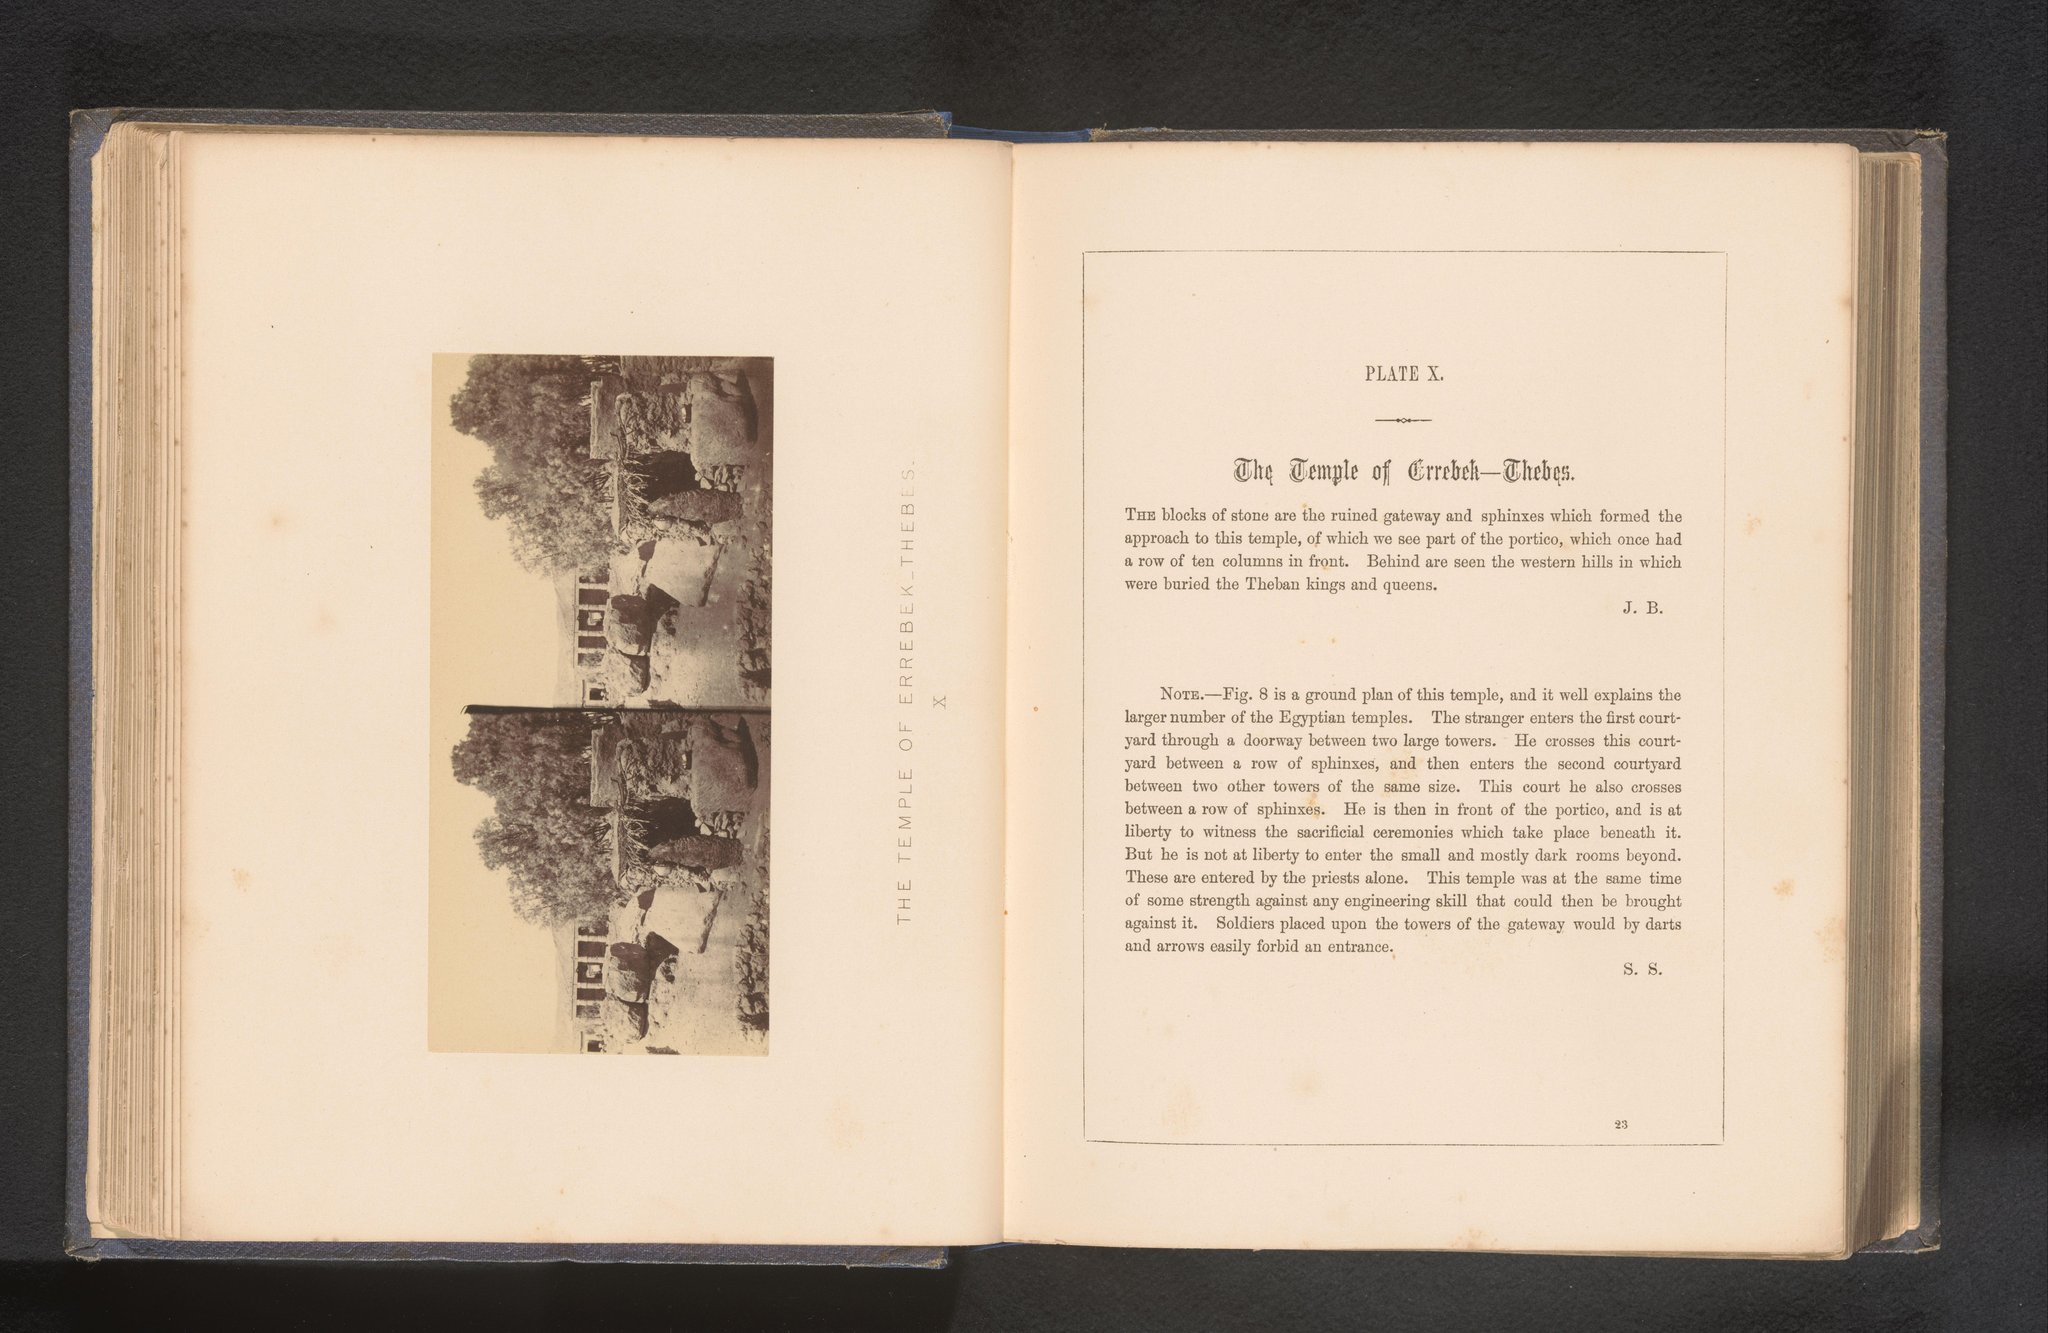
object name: stereograph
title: The temple of Errebek, Thebes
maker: francis frith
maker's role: publisher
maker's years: 1822-1898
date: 1857-1862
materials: photographic support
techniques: albumen print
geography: dendera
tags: temple, shrine ~ egyptian religion, thebes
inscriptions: number: ‘X’, name: ‘Frith’